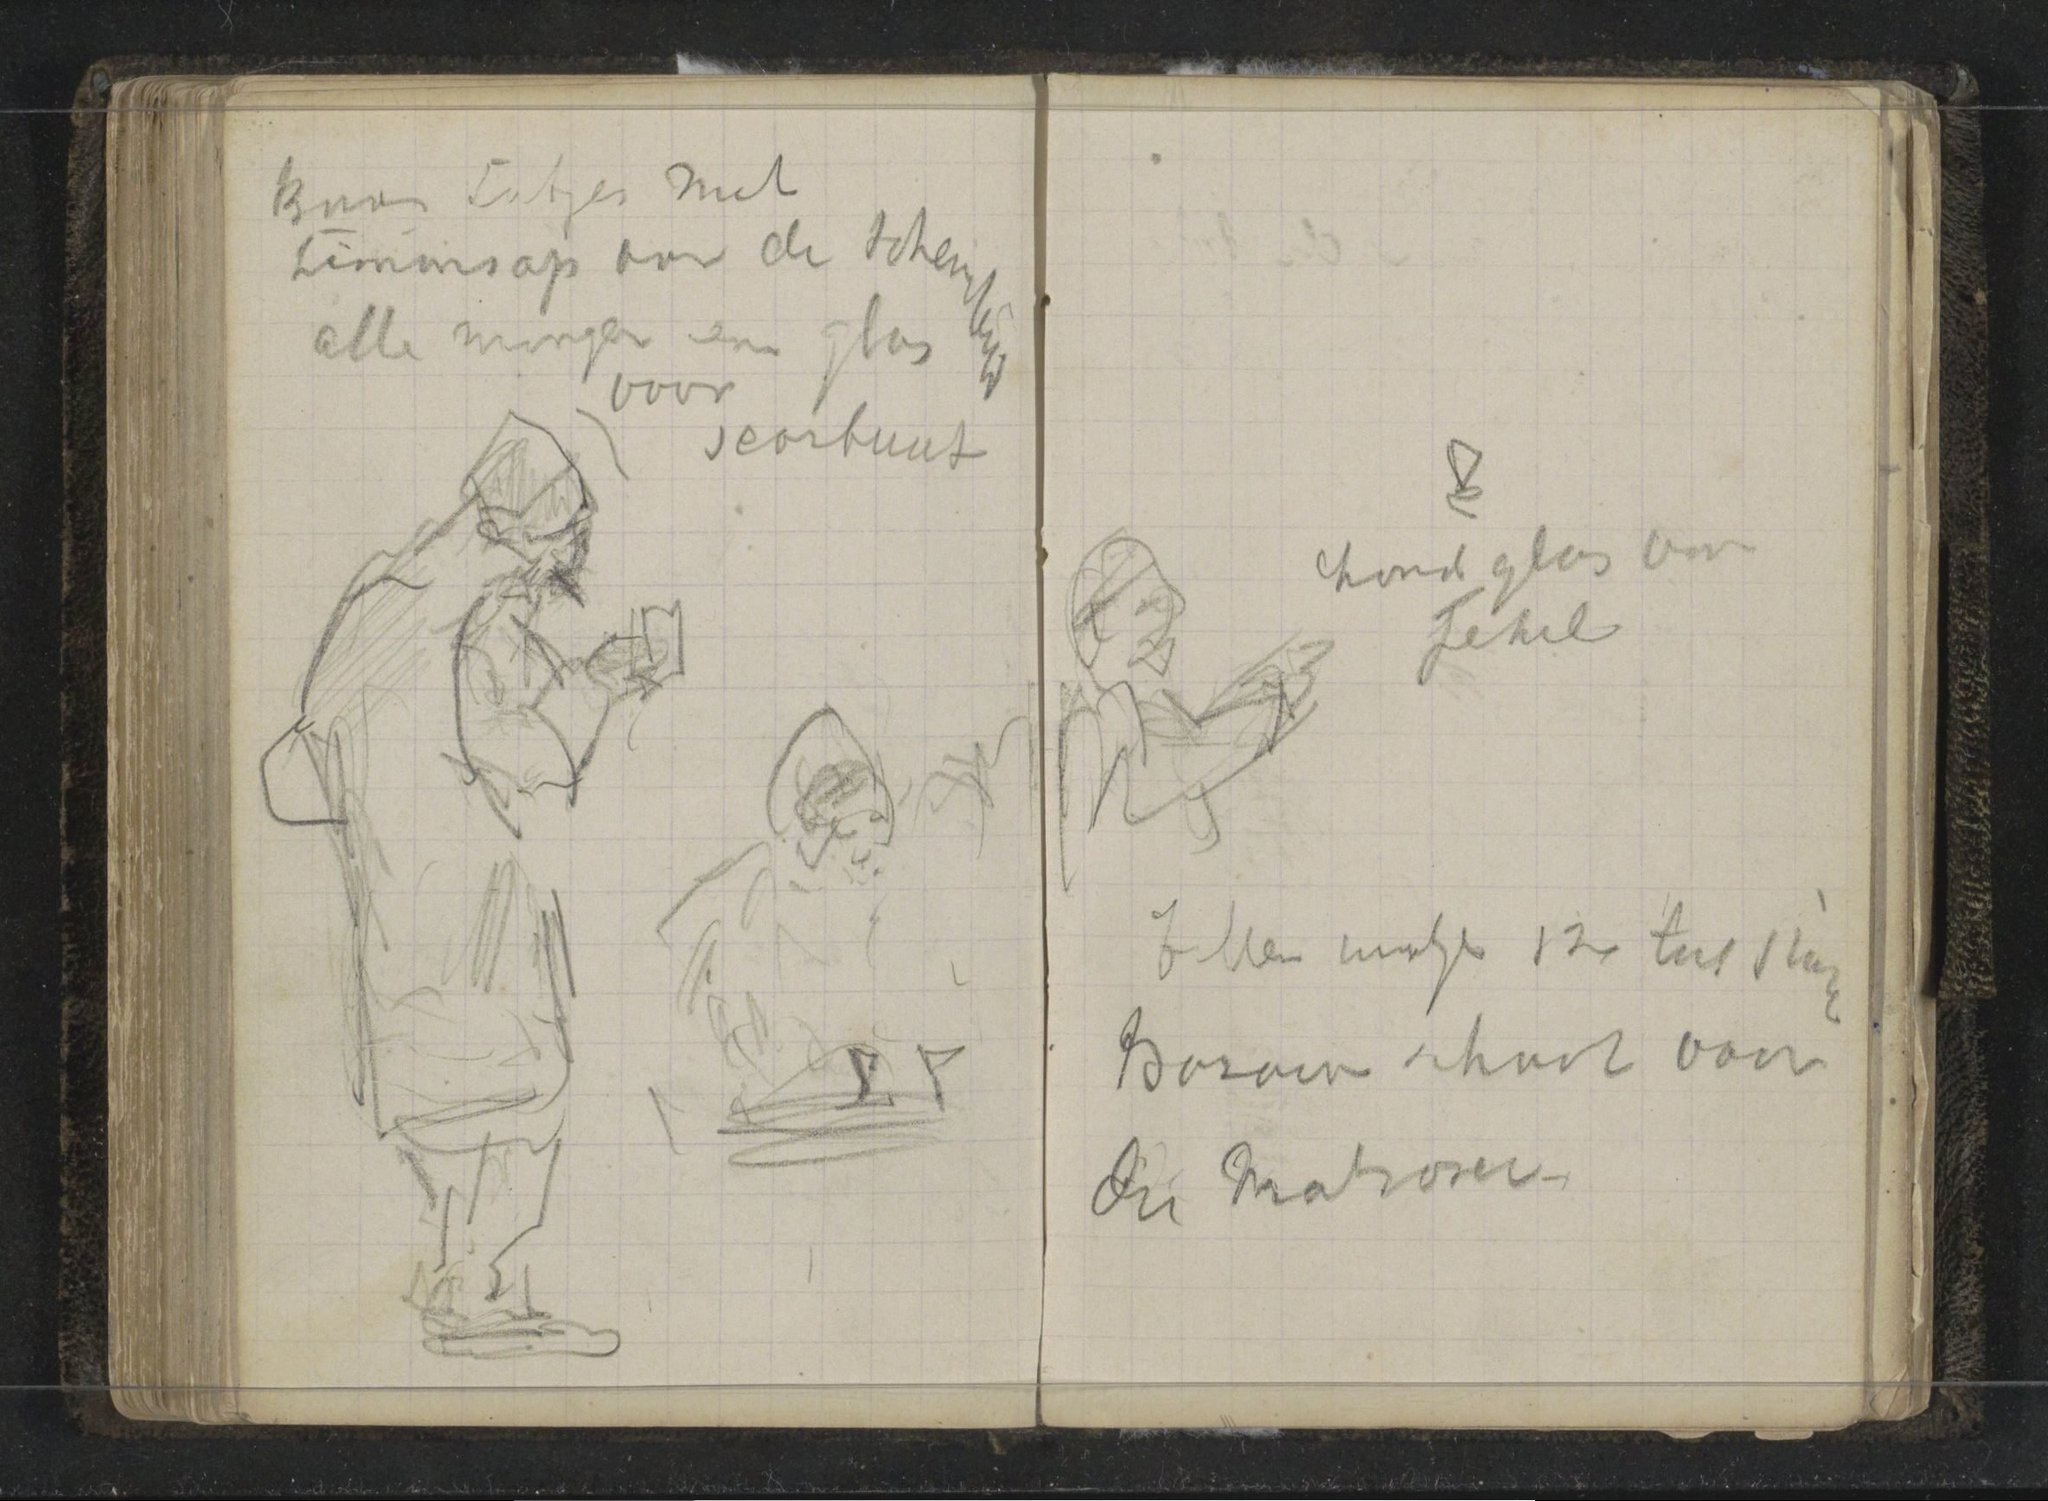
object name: sketchbook leaf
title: Bemanningsleden van de Willem Barentsz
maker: louis apol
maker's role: draughtsman, painter, print maker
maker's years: 1850-1936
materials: pencil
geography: novaya zemlya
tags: crew ~ ship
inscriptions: annotation: ‘Baas Latjes met / limonsap voor de scheurbuik / [...]’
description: Links Latjes met een glas citroensap. Blad 81 verso en blad 82 recto uit een schetsboek met 110 bladen betekend tijdens de expeditie naar Nova Zembla in 1880.